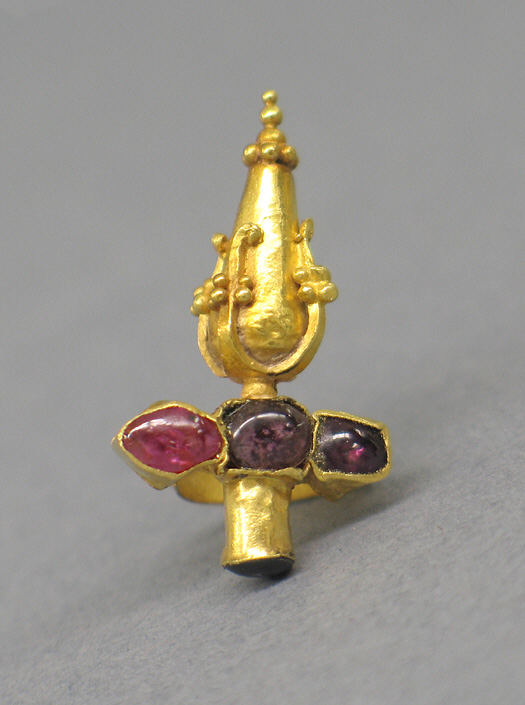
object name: ear clip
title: Pair of Ear Clips with Lavender Stones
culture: indonesian, javanese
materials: gold, stone